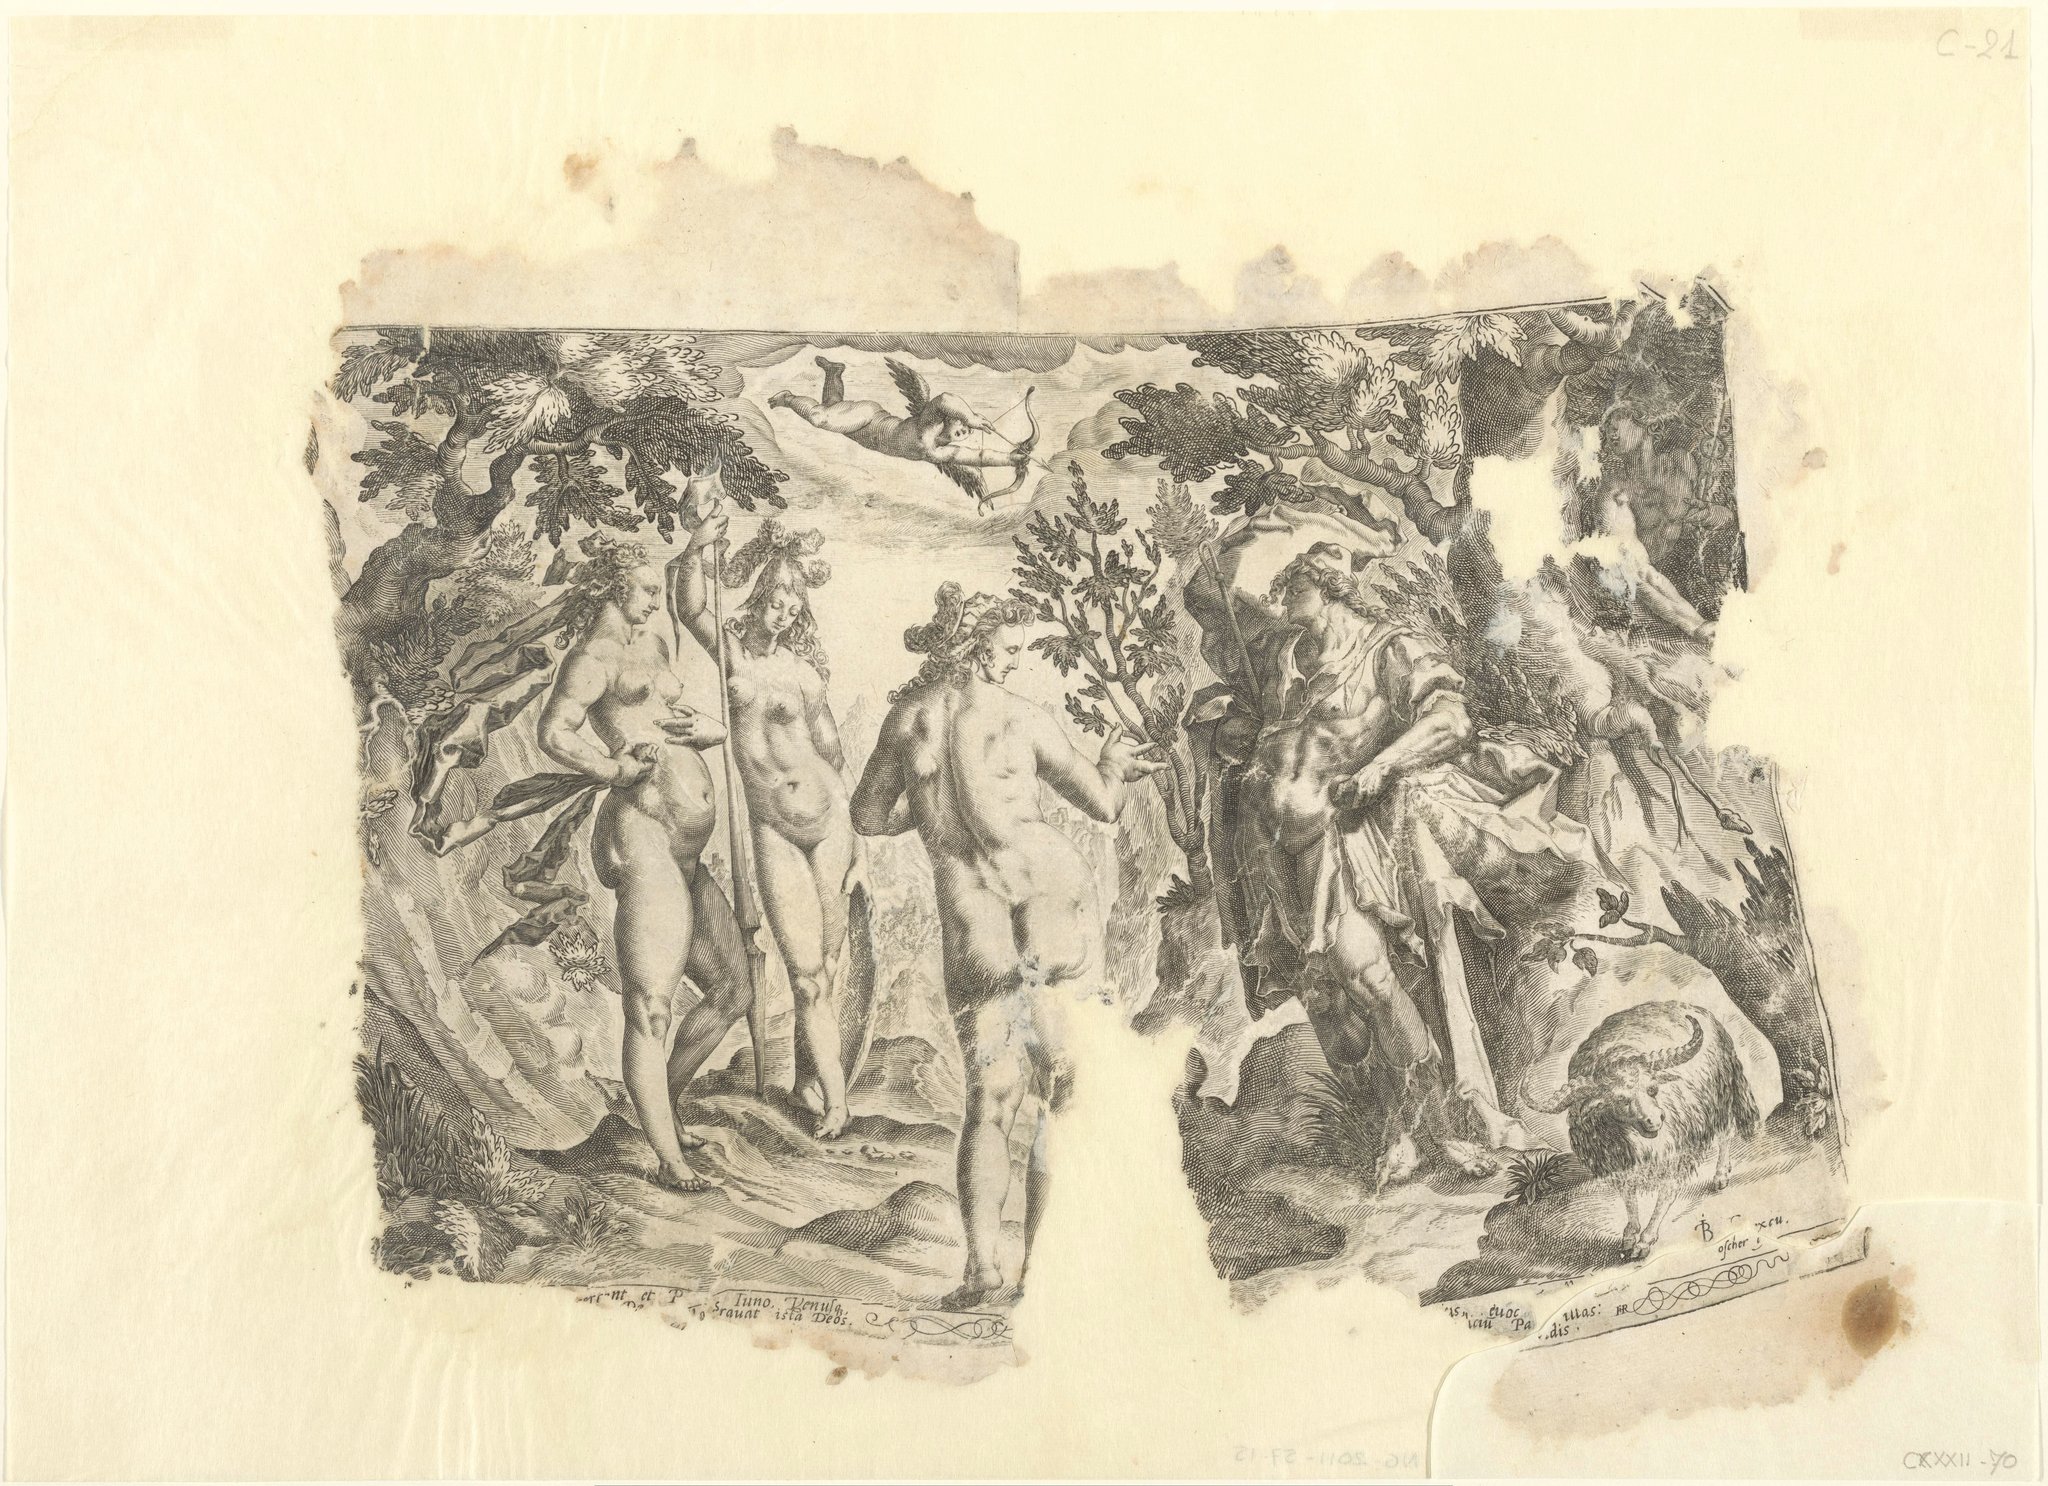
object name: print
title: Oordeel van Paris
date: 1580-1596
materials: paper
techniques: engraving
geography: amsterdam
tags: the judgement of paris (mercury present)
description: De prenten in de Nova Zembla collectie zijn tijdens een expeditie van Willem Barendsz en Jacob van Heemskerk in 1596-1597 noodgedwongen in het winterkamp, het ‘Behouden Huis’, op het eiland achtergelaten. De prenten waren in één of meerdere stapels als handelswaar meegenomen vanuit Amsterdam. Bijna drie eeuwen later, in 1871, keerde de Noor Elling Carlsen terug naar Nova Zembla en vond daar de restanten van het ‘Behouden Huis, inclusief een groot deel van de inventaris. Een deel van de prenten, in de vorm van aaneengekoekte kluiten, werd toen ook teruggevonden. De papierkluiten waren soms op meerdere plekken gebroken. Tussen 1975-1979 zijn de prenten van elkaar gescheiden. Dit leverde in totaal ca. 1000 fragmenten van ca. 400 afdrukken van ca. 150 verschillende prenten op. Voor zover mogelijk zijn de fragmenten samengevoegd en zijn de prenten gereconstrueerd.